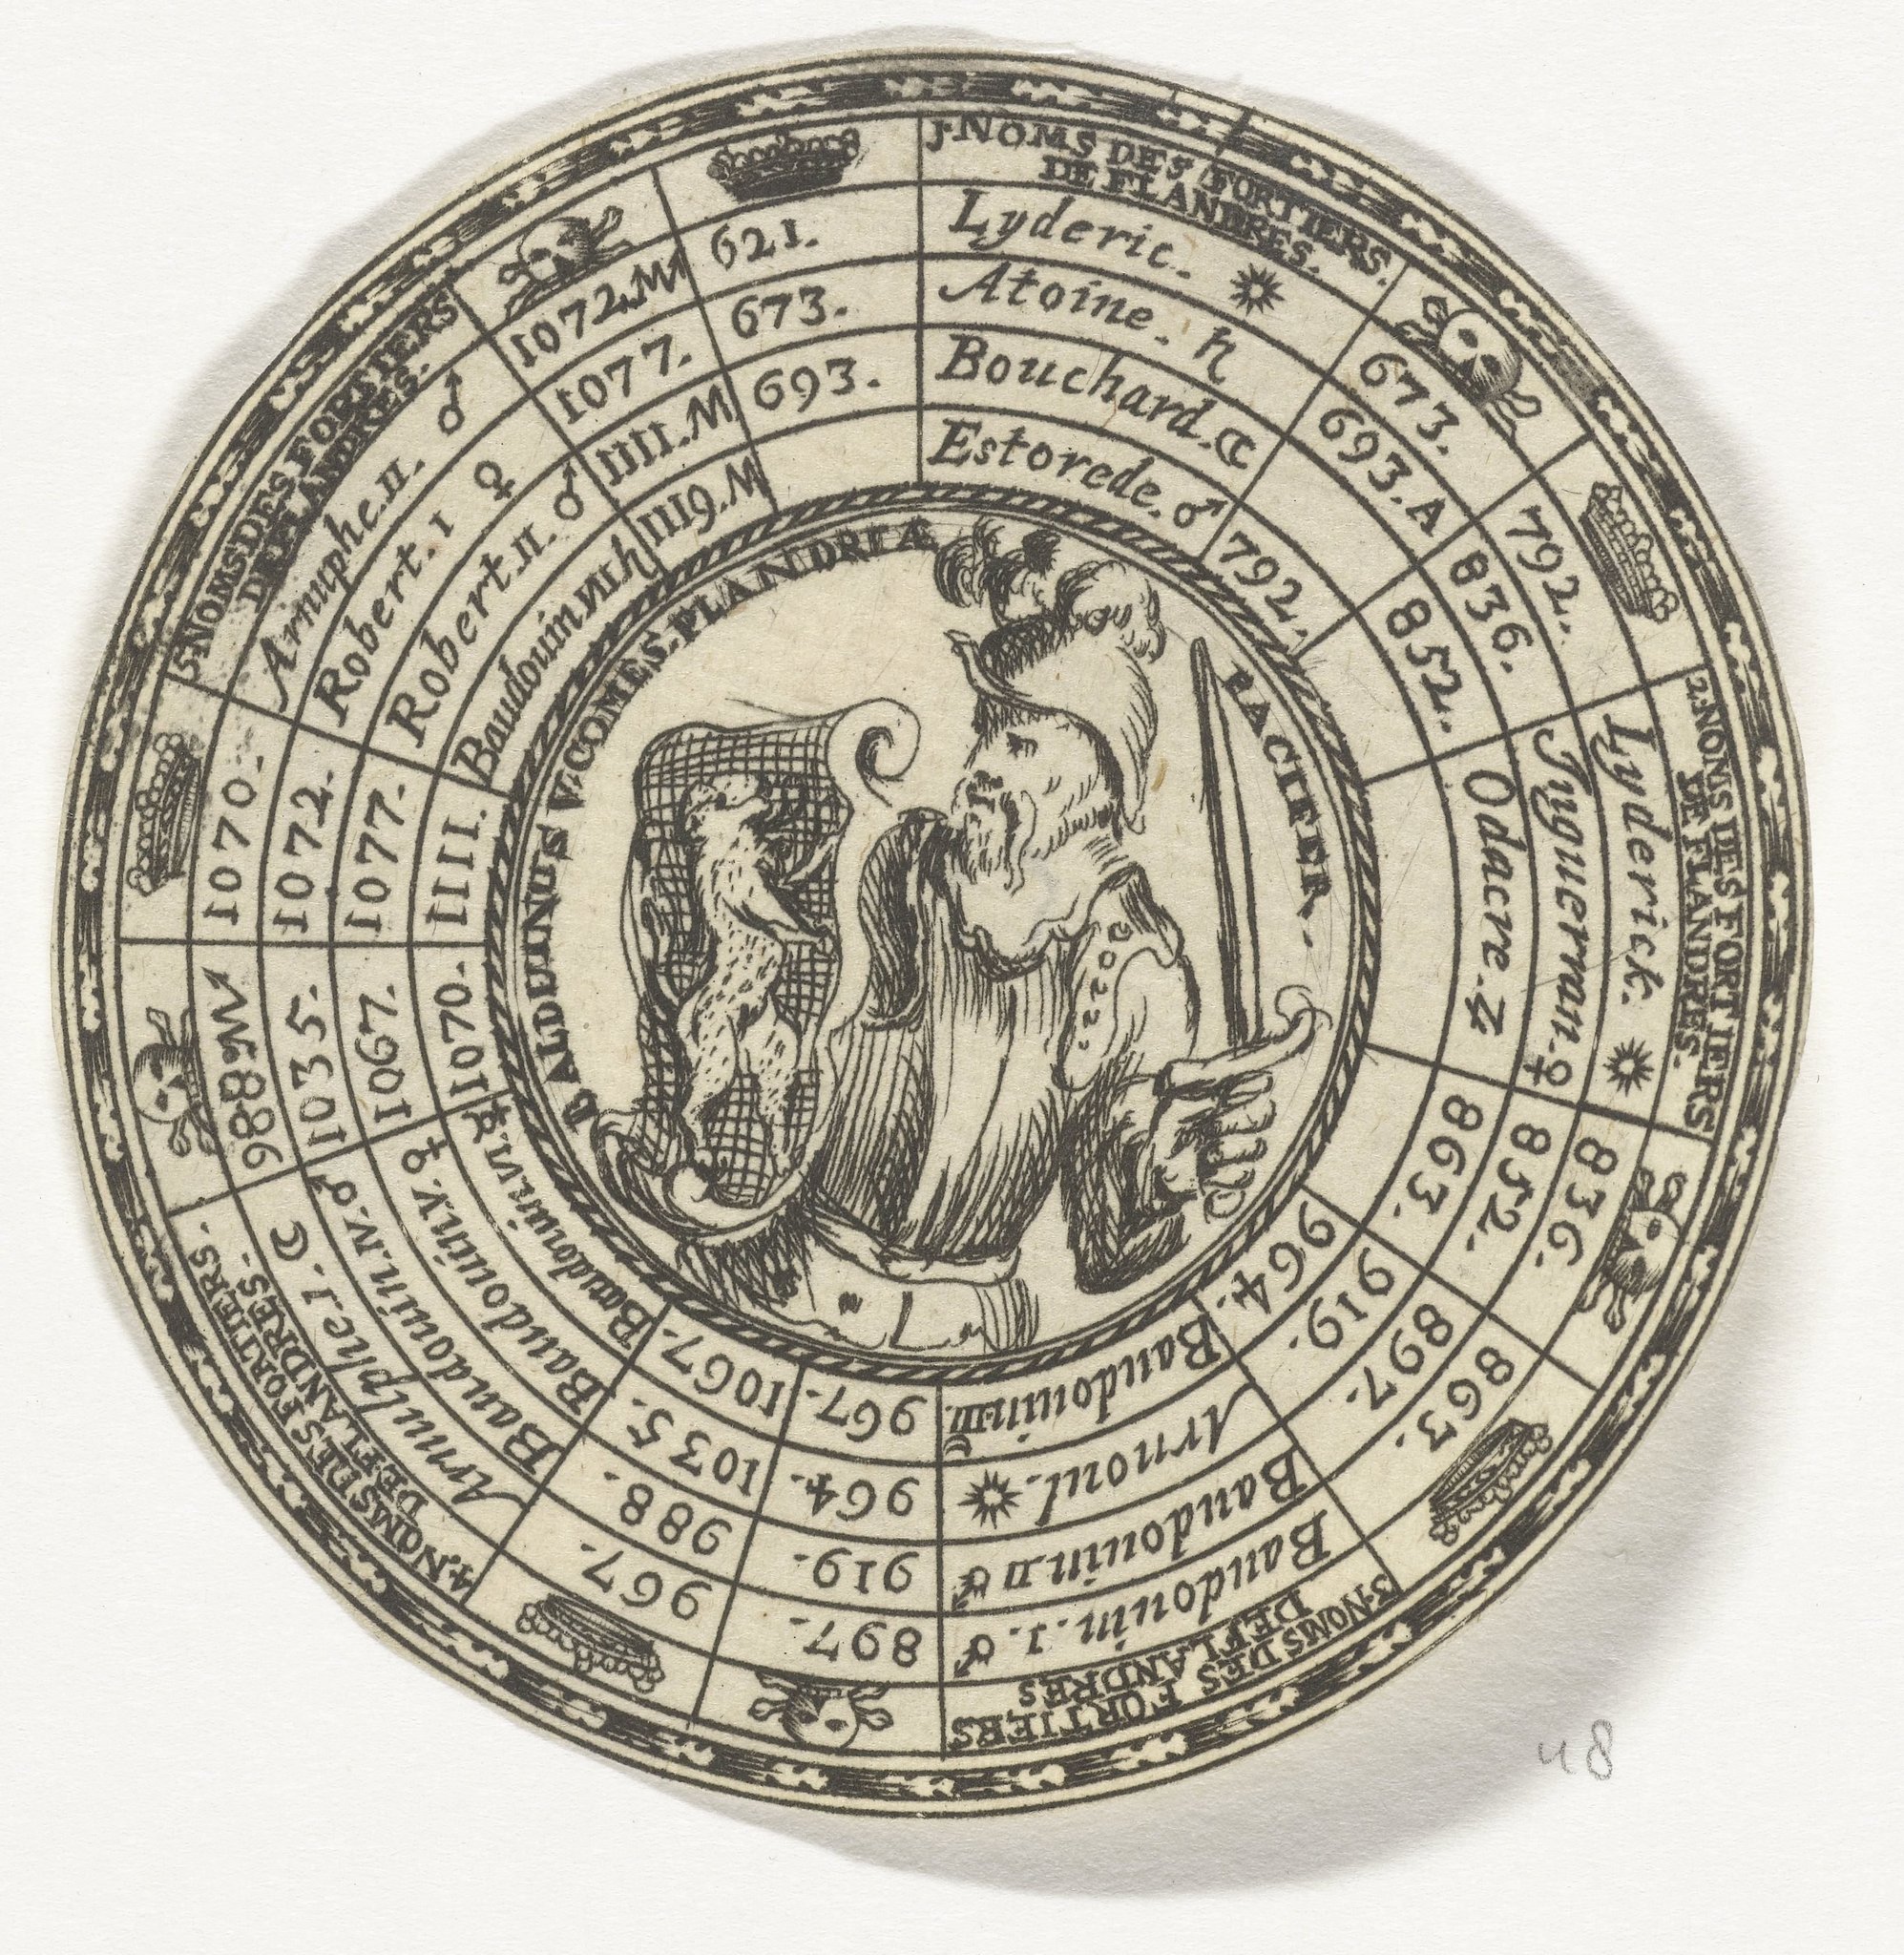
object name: print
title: Penning met het portret van Boudewijn V en de namen van de graven van Vlaanderen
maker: Anonymous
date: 1685-1720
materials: paper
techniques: etching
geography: amsterdam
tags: baldwin v (count of flanders), feudal lord, seal (symbol of sovereignty)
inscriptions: number: ‘51’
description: Ontwerp van een ronde penning met, in vijf concentrische cirkels, de namen van de graven van Vlaanderen en hun regeringsjaren, beginnende bij graaf Liederik I en eindigend bij Boudewijn VI van Vlaanderen. In het midden van de penning het portret van graaf Boudewijn V van Vlaanderen.